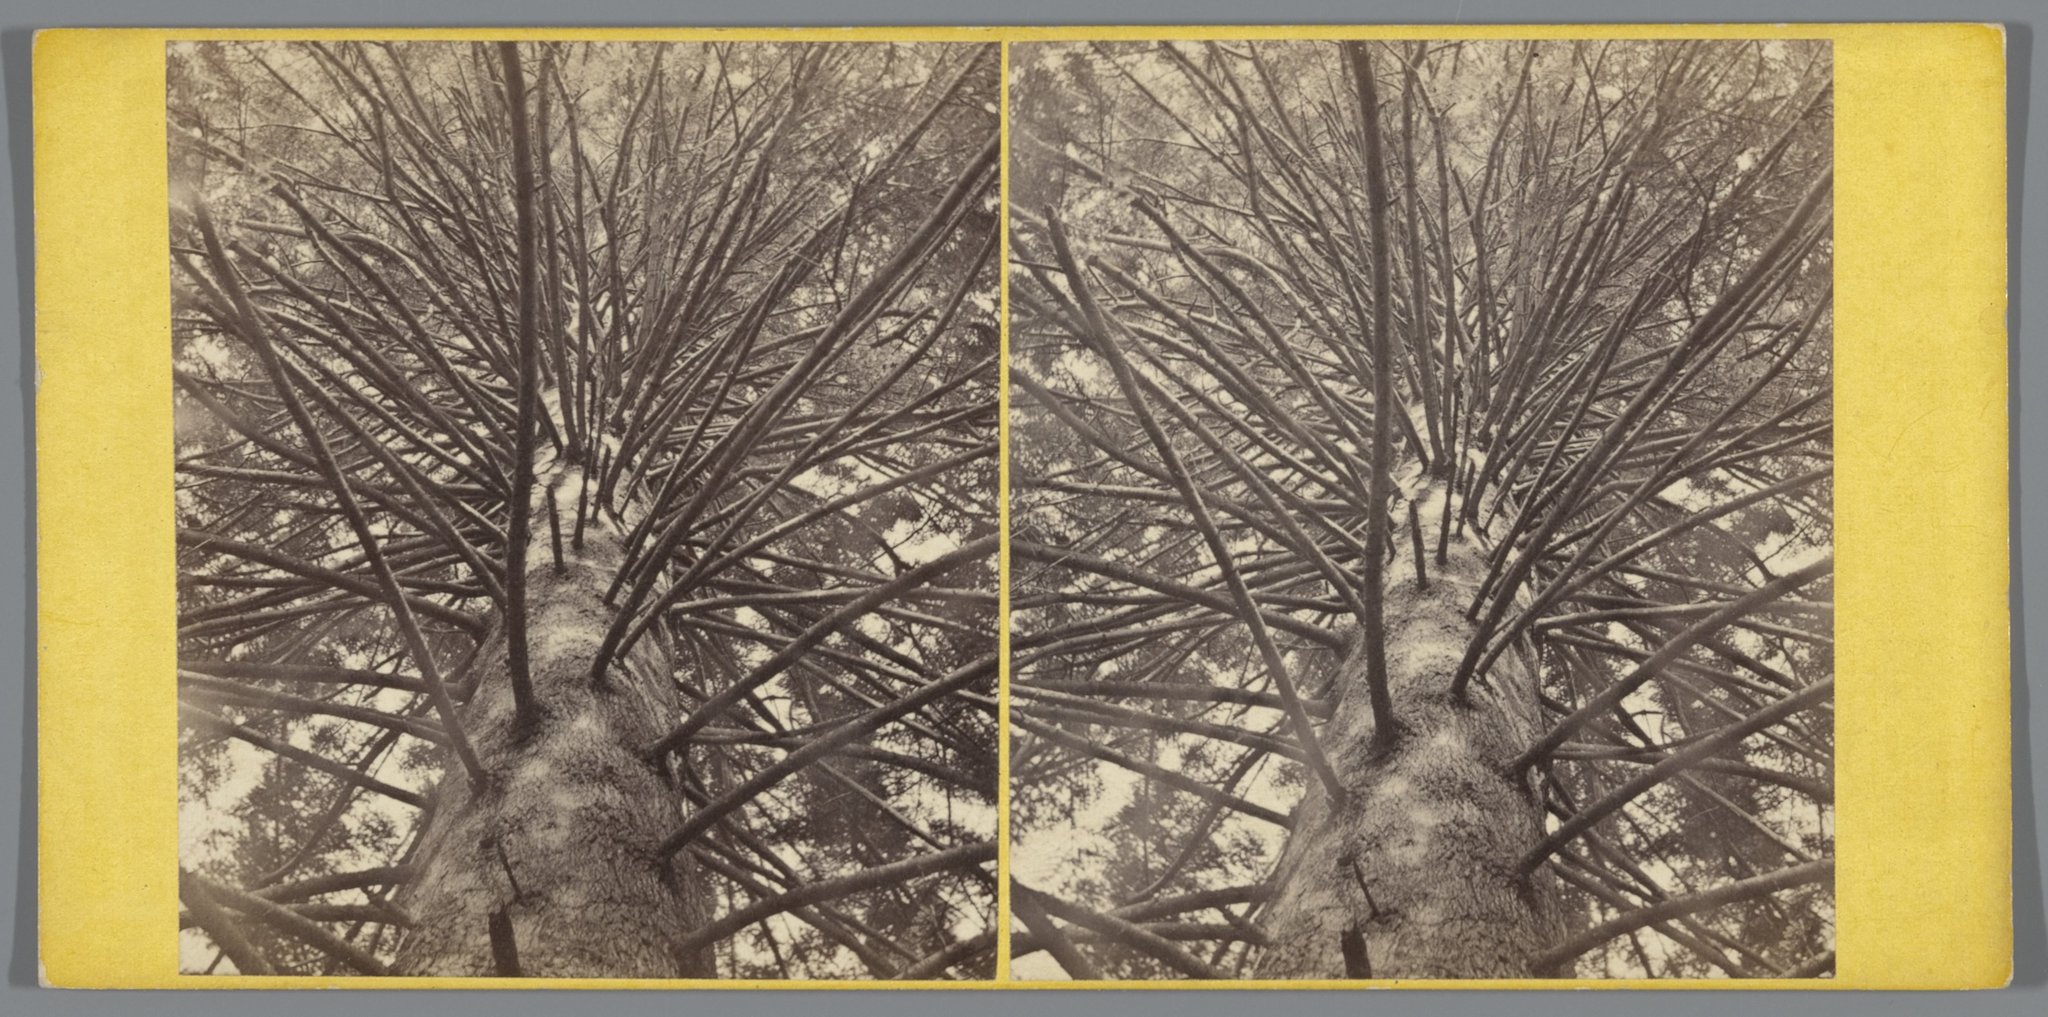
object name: stereograph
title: Silver Fir Tree at Dunkeld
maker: george washington wilson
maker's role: publisher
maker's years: 1823-1893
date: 1870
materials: cardboard, photographic support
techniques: albumen print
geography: dunkeld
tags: trees: fir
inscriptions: number: ‘No. 784.’